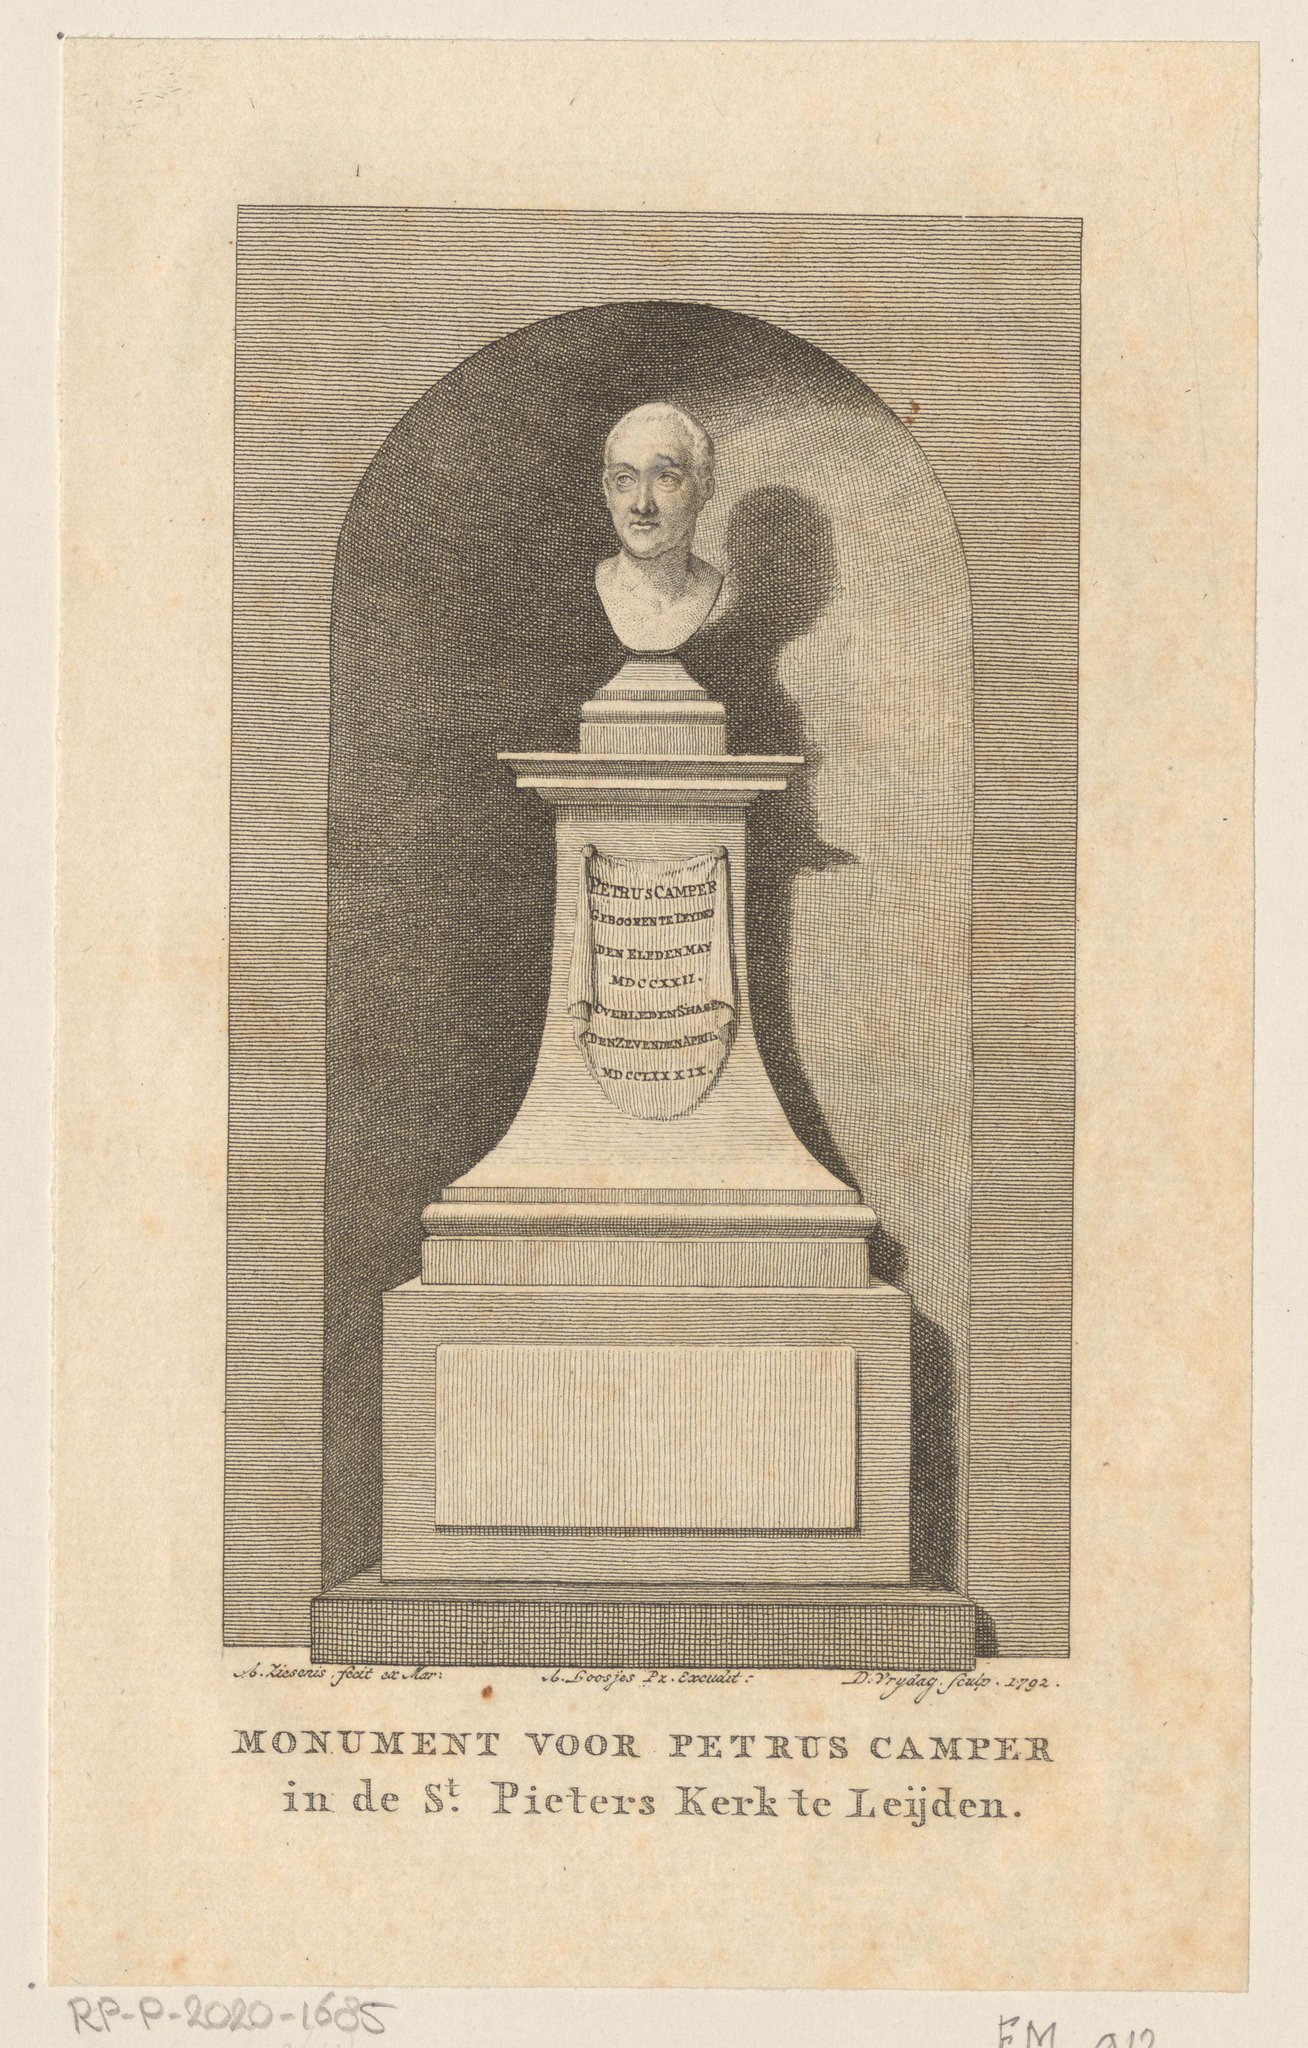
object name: book illustration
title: Grafmonument voor Petrus Camper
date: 1792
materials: paper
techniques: engraving, etching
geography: haarlem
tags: leiden, print maker, draughtsman, petrus camper, historical persons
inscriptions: collector's mark: Lugt 964